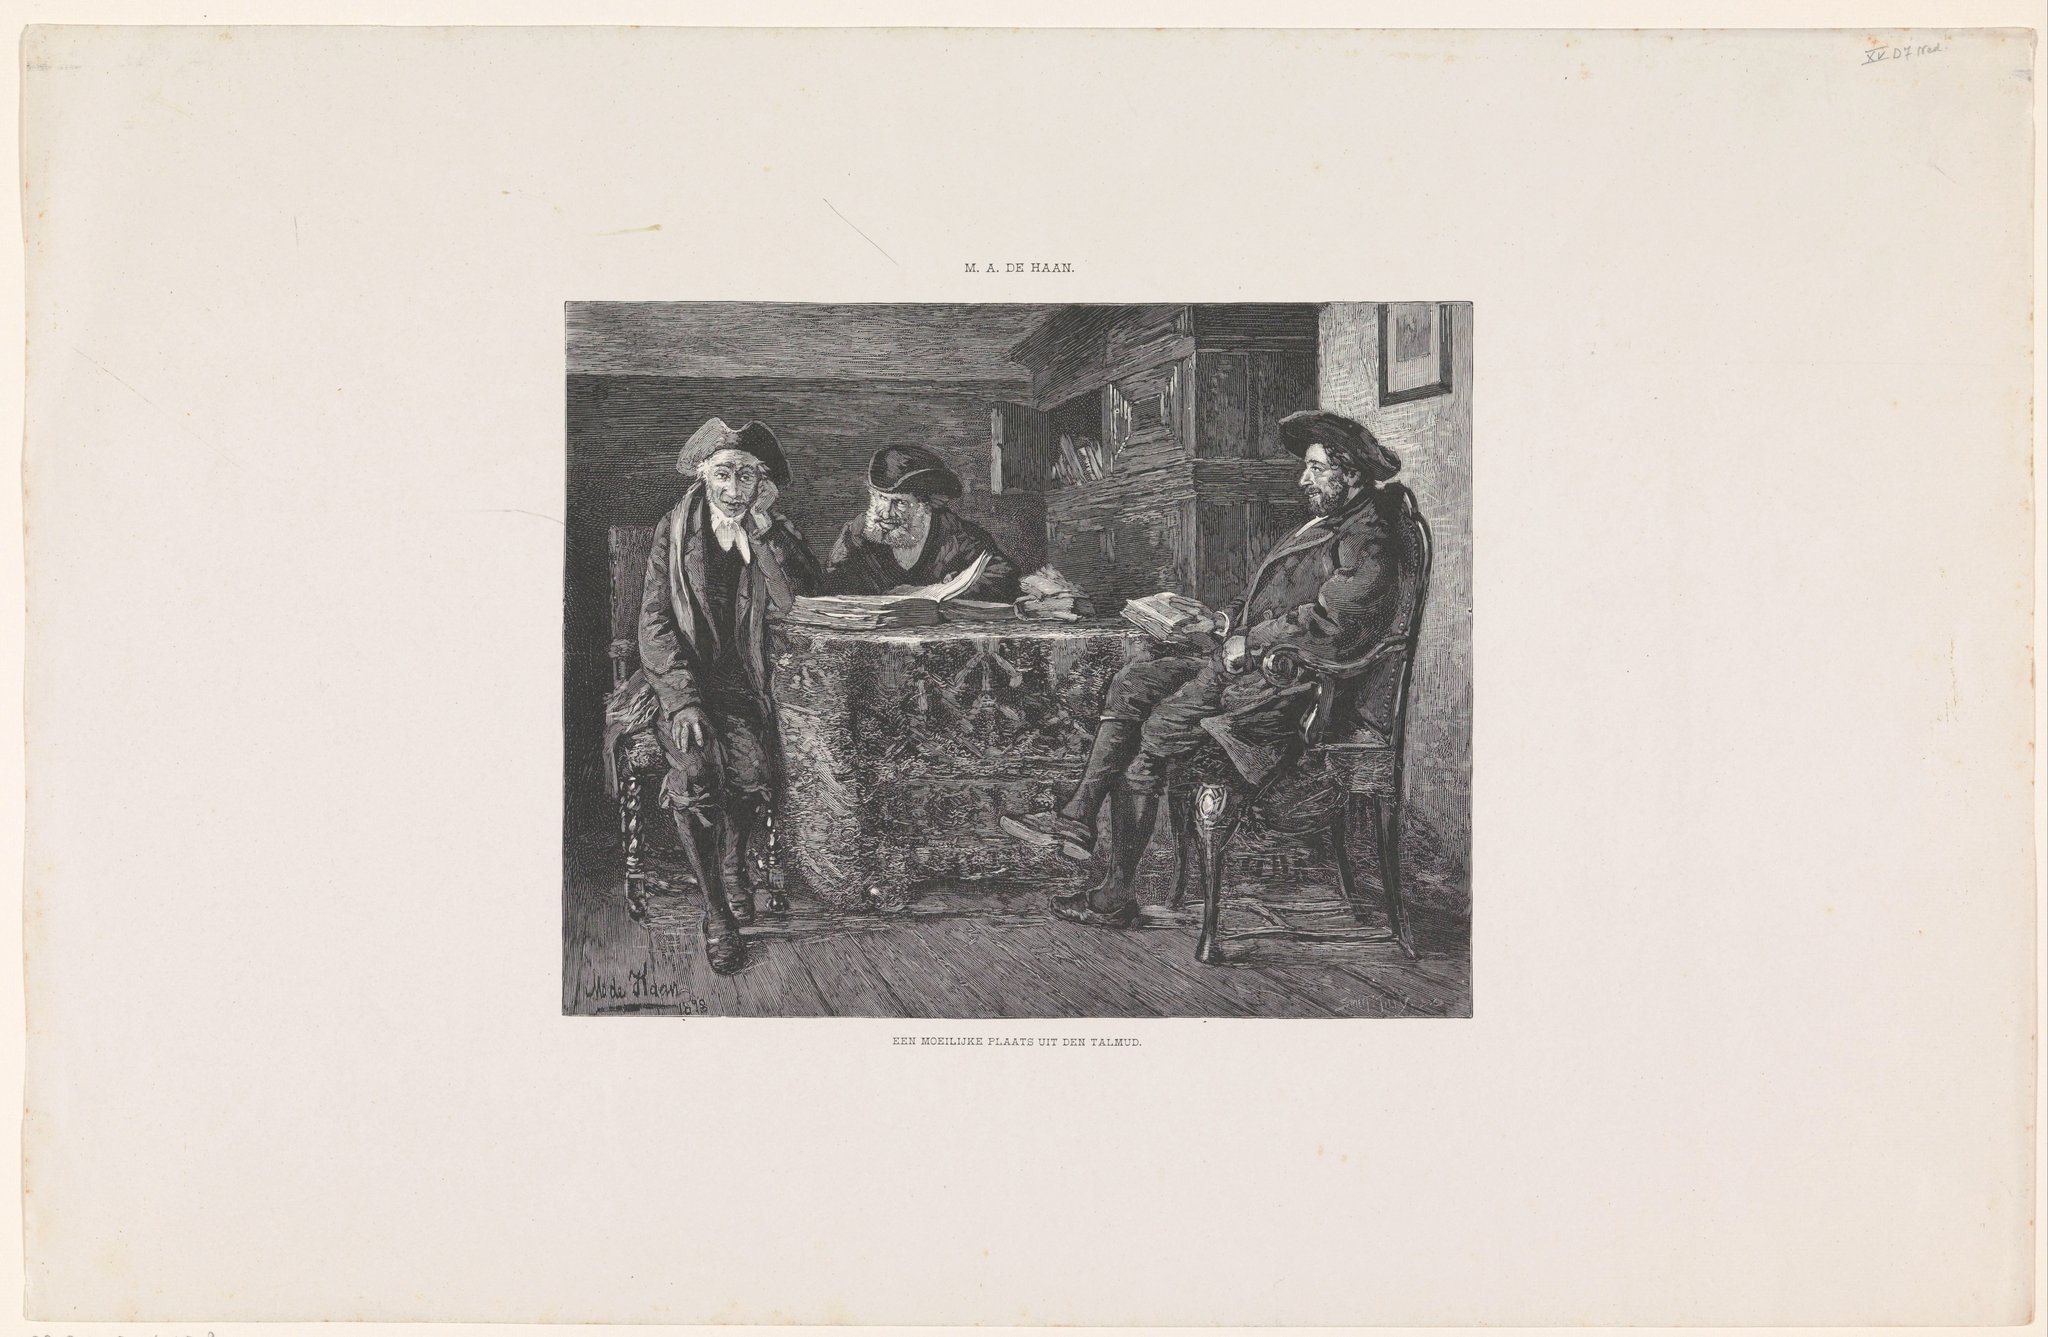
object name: print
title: Een moeilijke plaats uit den talmud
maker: meijer isaäc de haan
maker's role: painter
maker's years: 1852-1895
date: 1878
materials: paper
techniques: engraving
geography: paris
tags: studying the torah, the talmud, etc. ~ personal duties in jewish life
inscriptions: collector's mark: Lugt 4780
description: Drie mannen met hoeden zitten rondom een tafel met daarop een aantal boeken. Op de achtergrond staat een deur van een kast open.